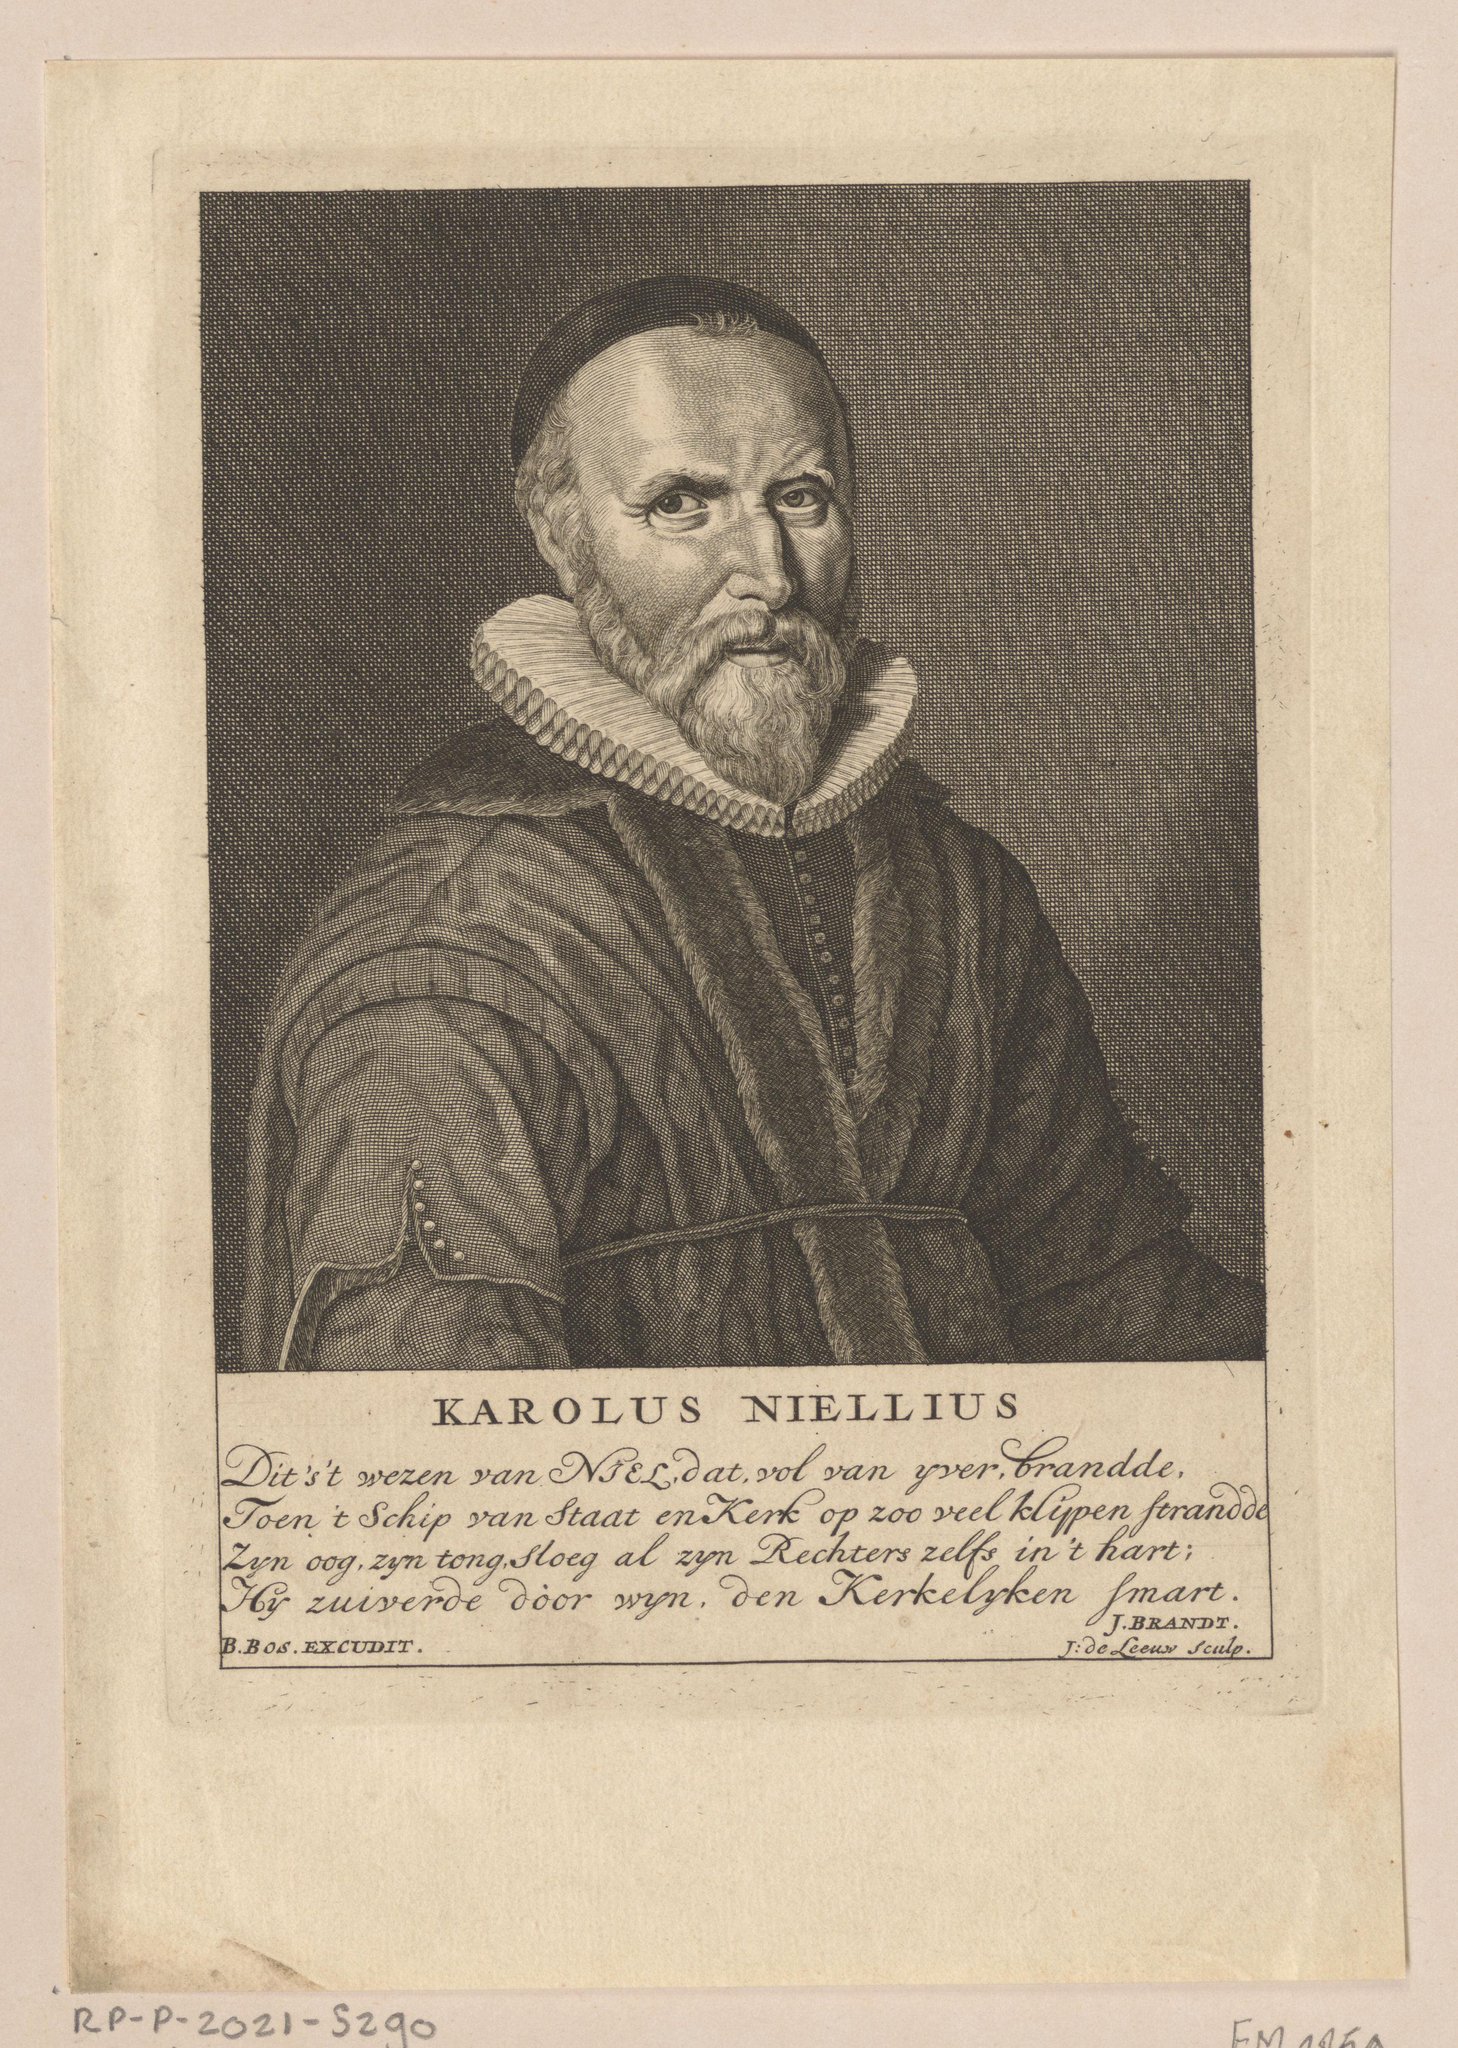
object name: print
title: Portret van Carolus Niellius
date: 1704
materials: paper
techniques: engraving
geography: rotterdam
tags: theologian, historical persons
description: Prent mogelijk uit: Brandt, Geeraert. G. Brandts historie der Reformatie, en andre kerkelyke geschiedenissen, in en ontrent de Nederlanden. Rotterdam: Barent Bos, 1704, dl. 4, tussen p. 490 en 491.